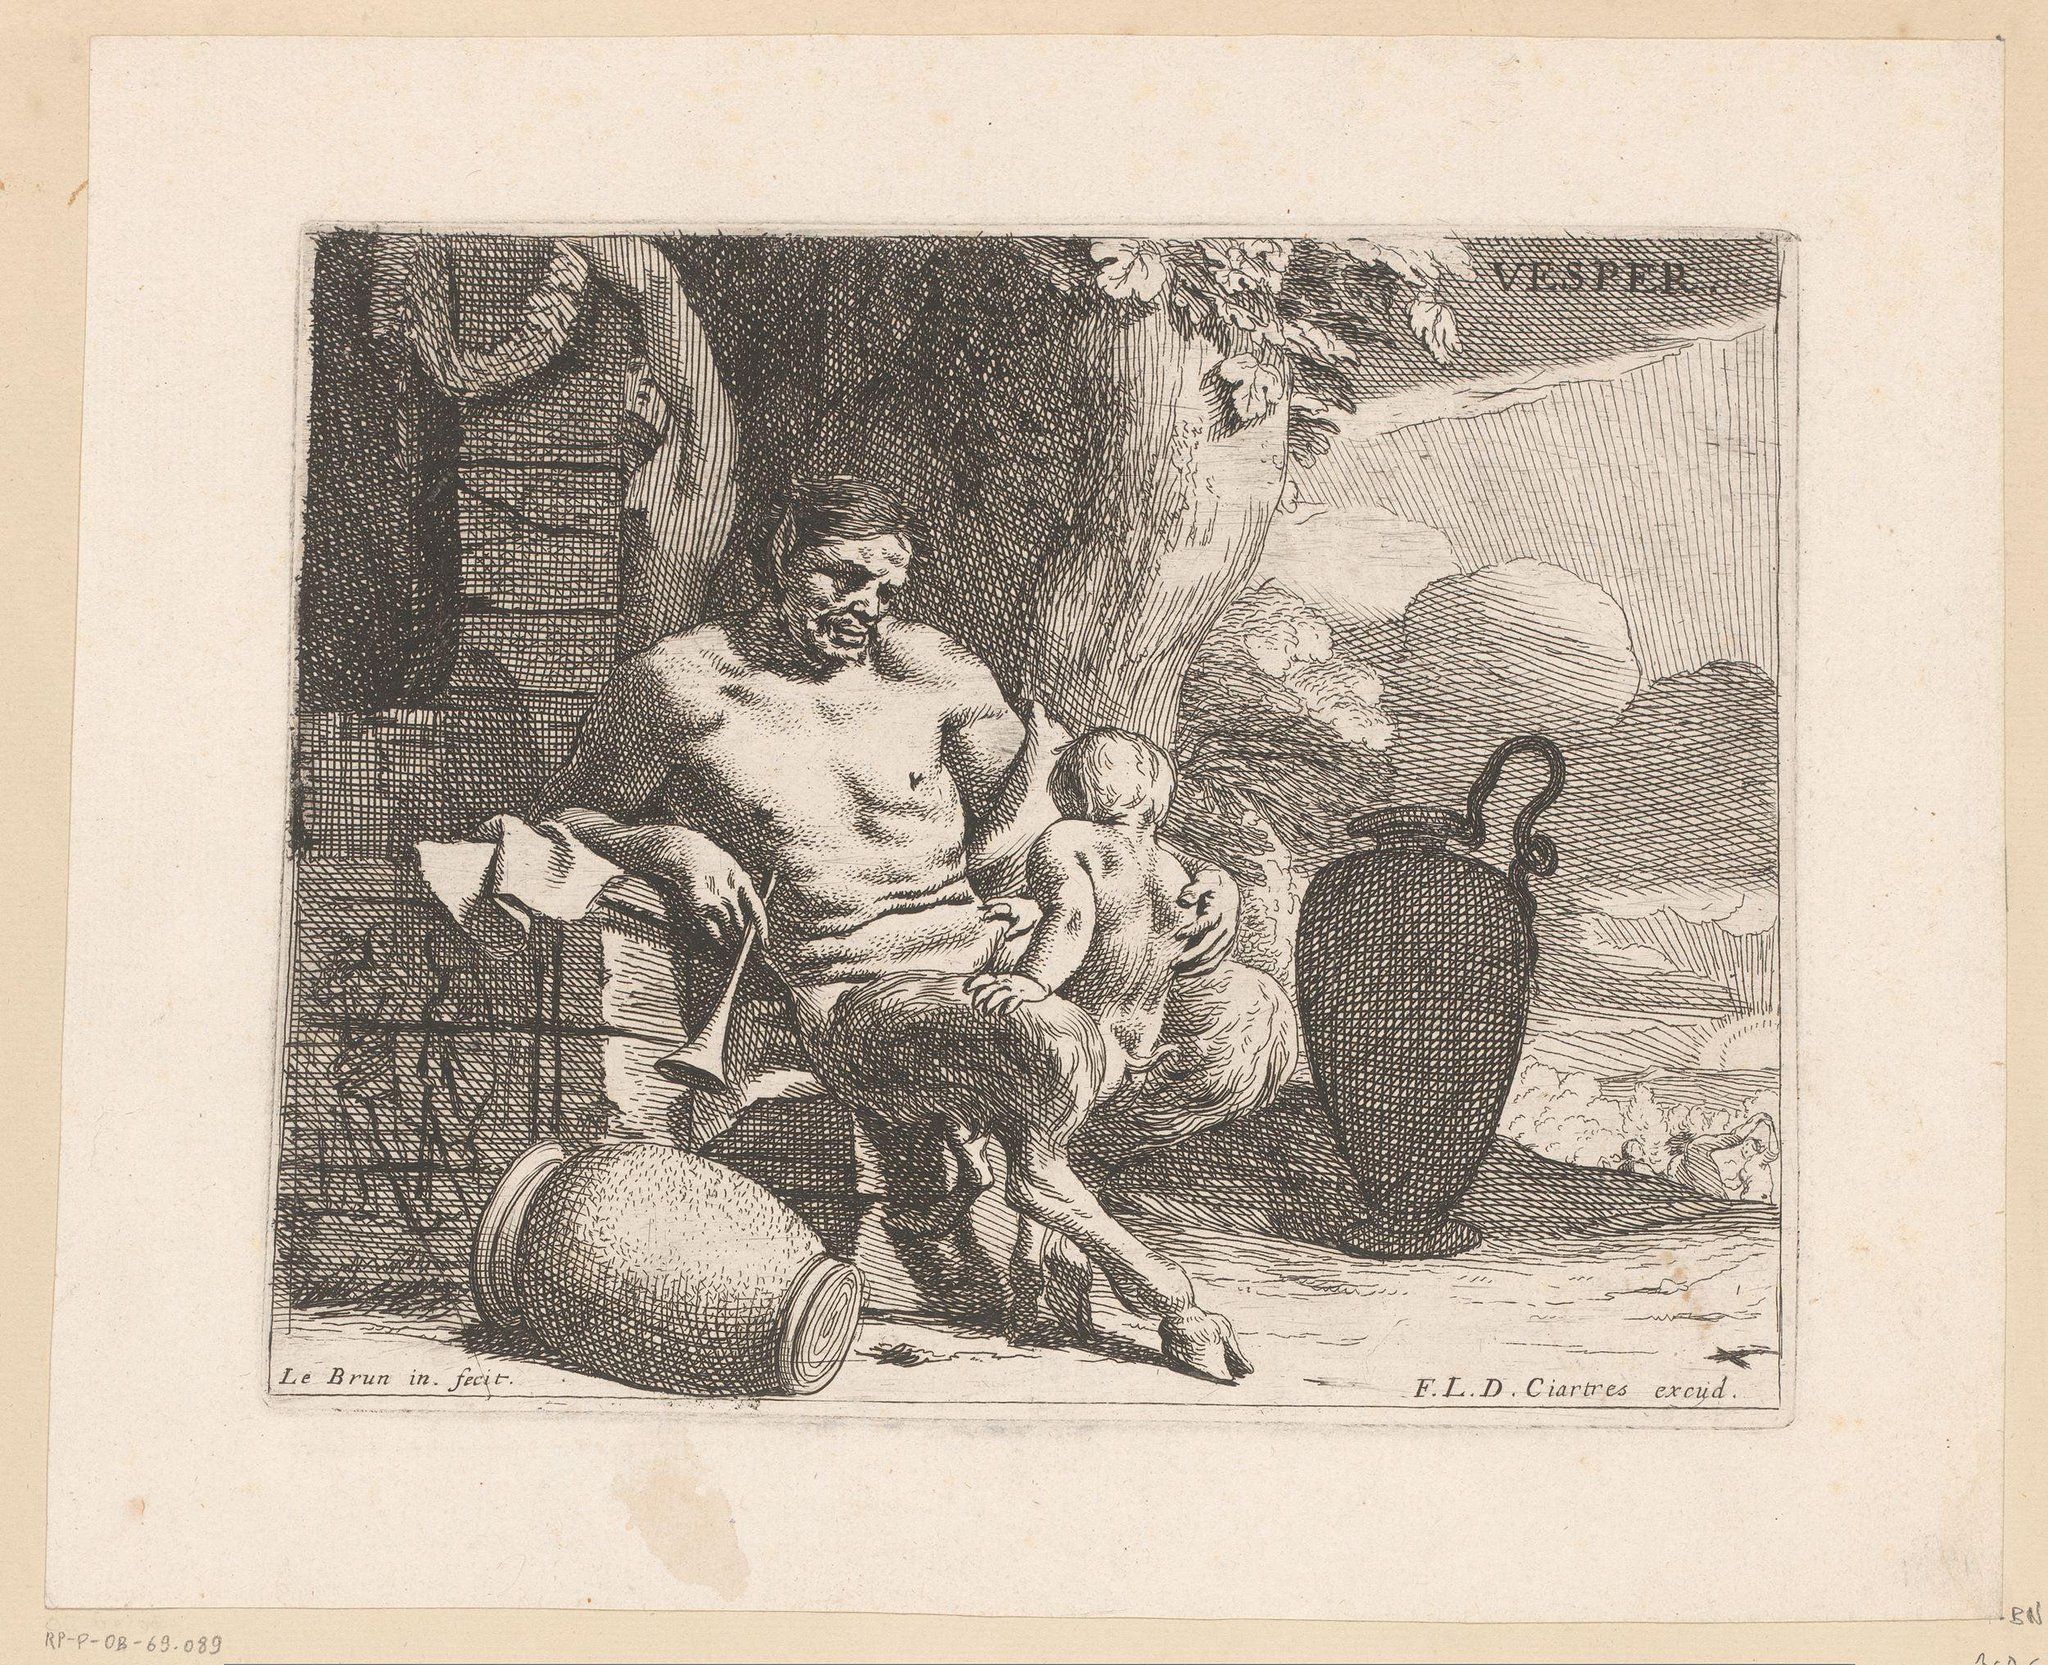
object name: print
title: Personificatie van verschillende tijdstippen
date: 1640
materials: paper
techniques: engraving, etching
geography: france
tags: personification of the evening, 'vesper', child, satyr(s) (in general)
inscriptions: collector's mark: Lugt 240